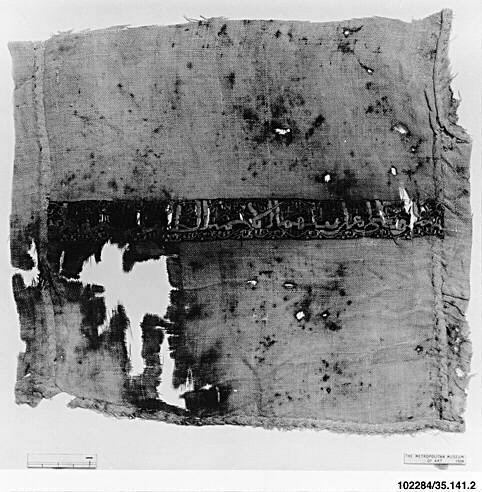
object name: textile fragment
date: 1101-1200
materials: linen, silk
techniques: tapestry, weave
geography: egypt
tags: arabic